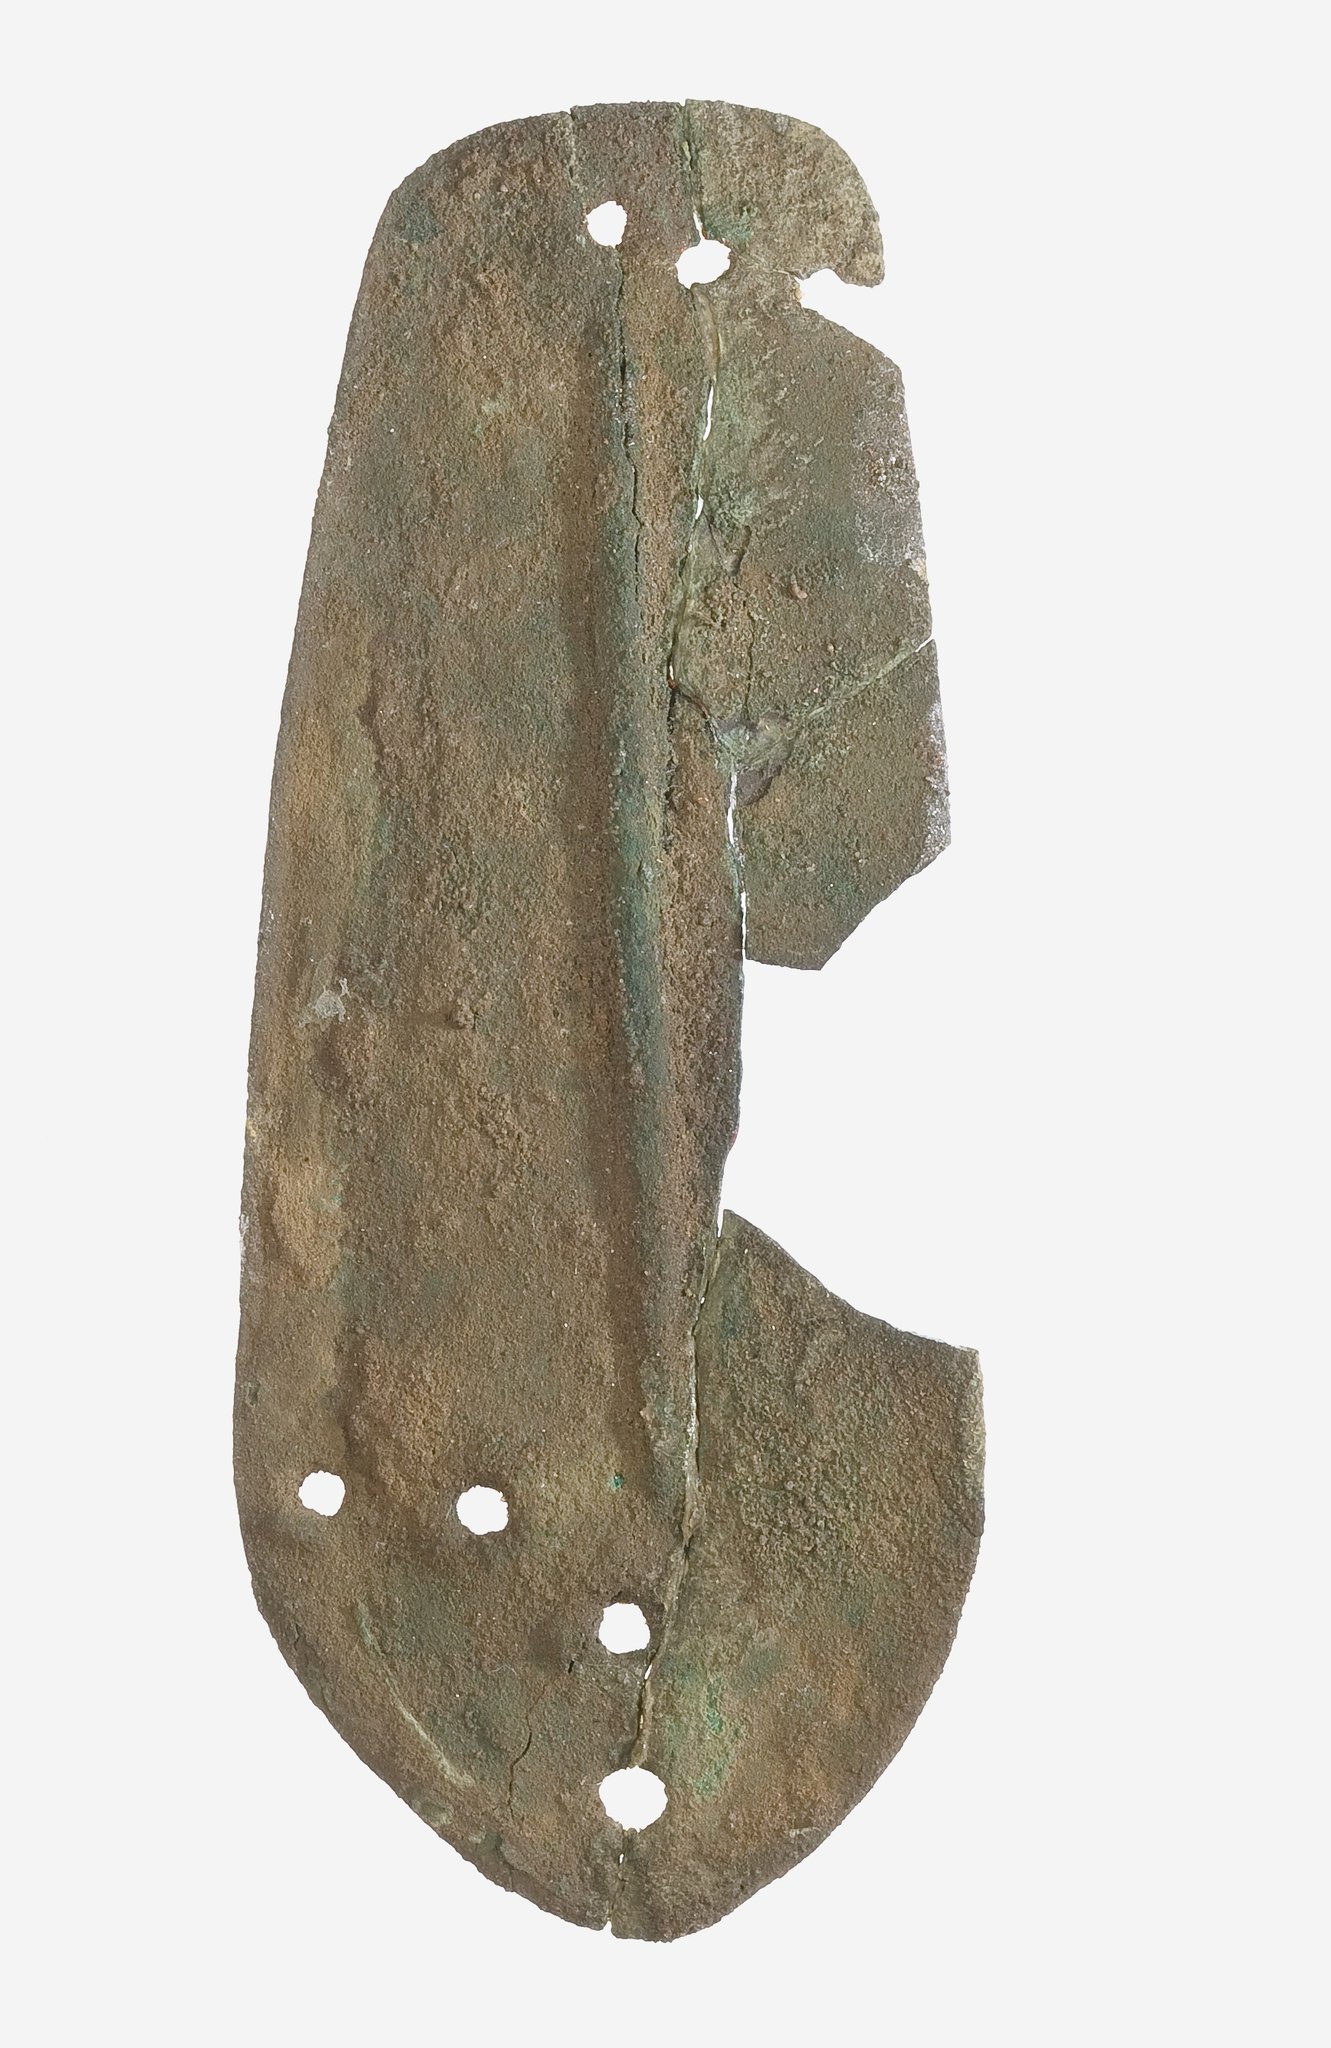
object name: armor scale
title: Scale from Armor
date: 1390-1352 BCE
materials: bronze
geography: egypt